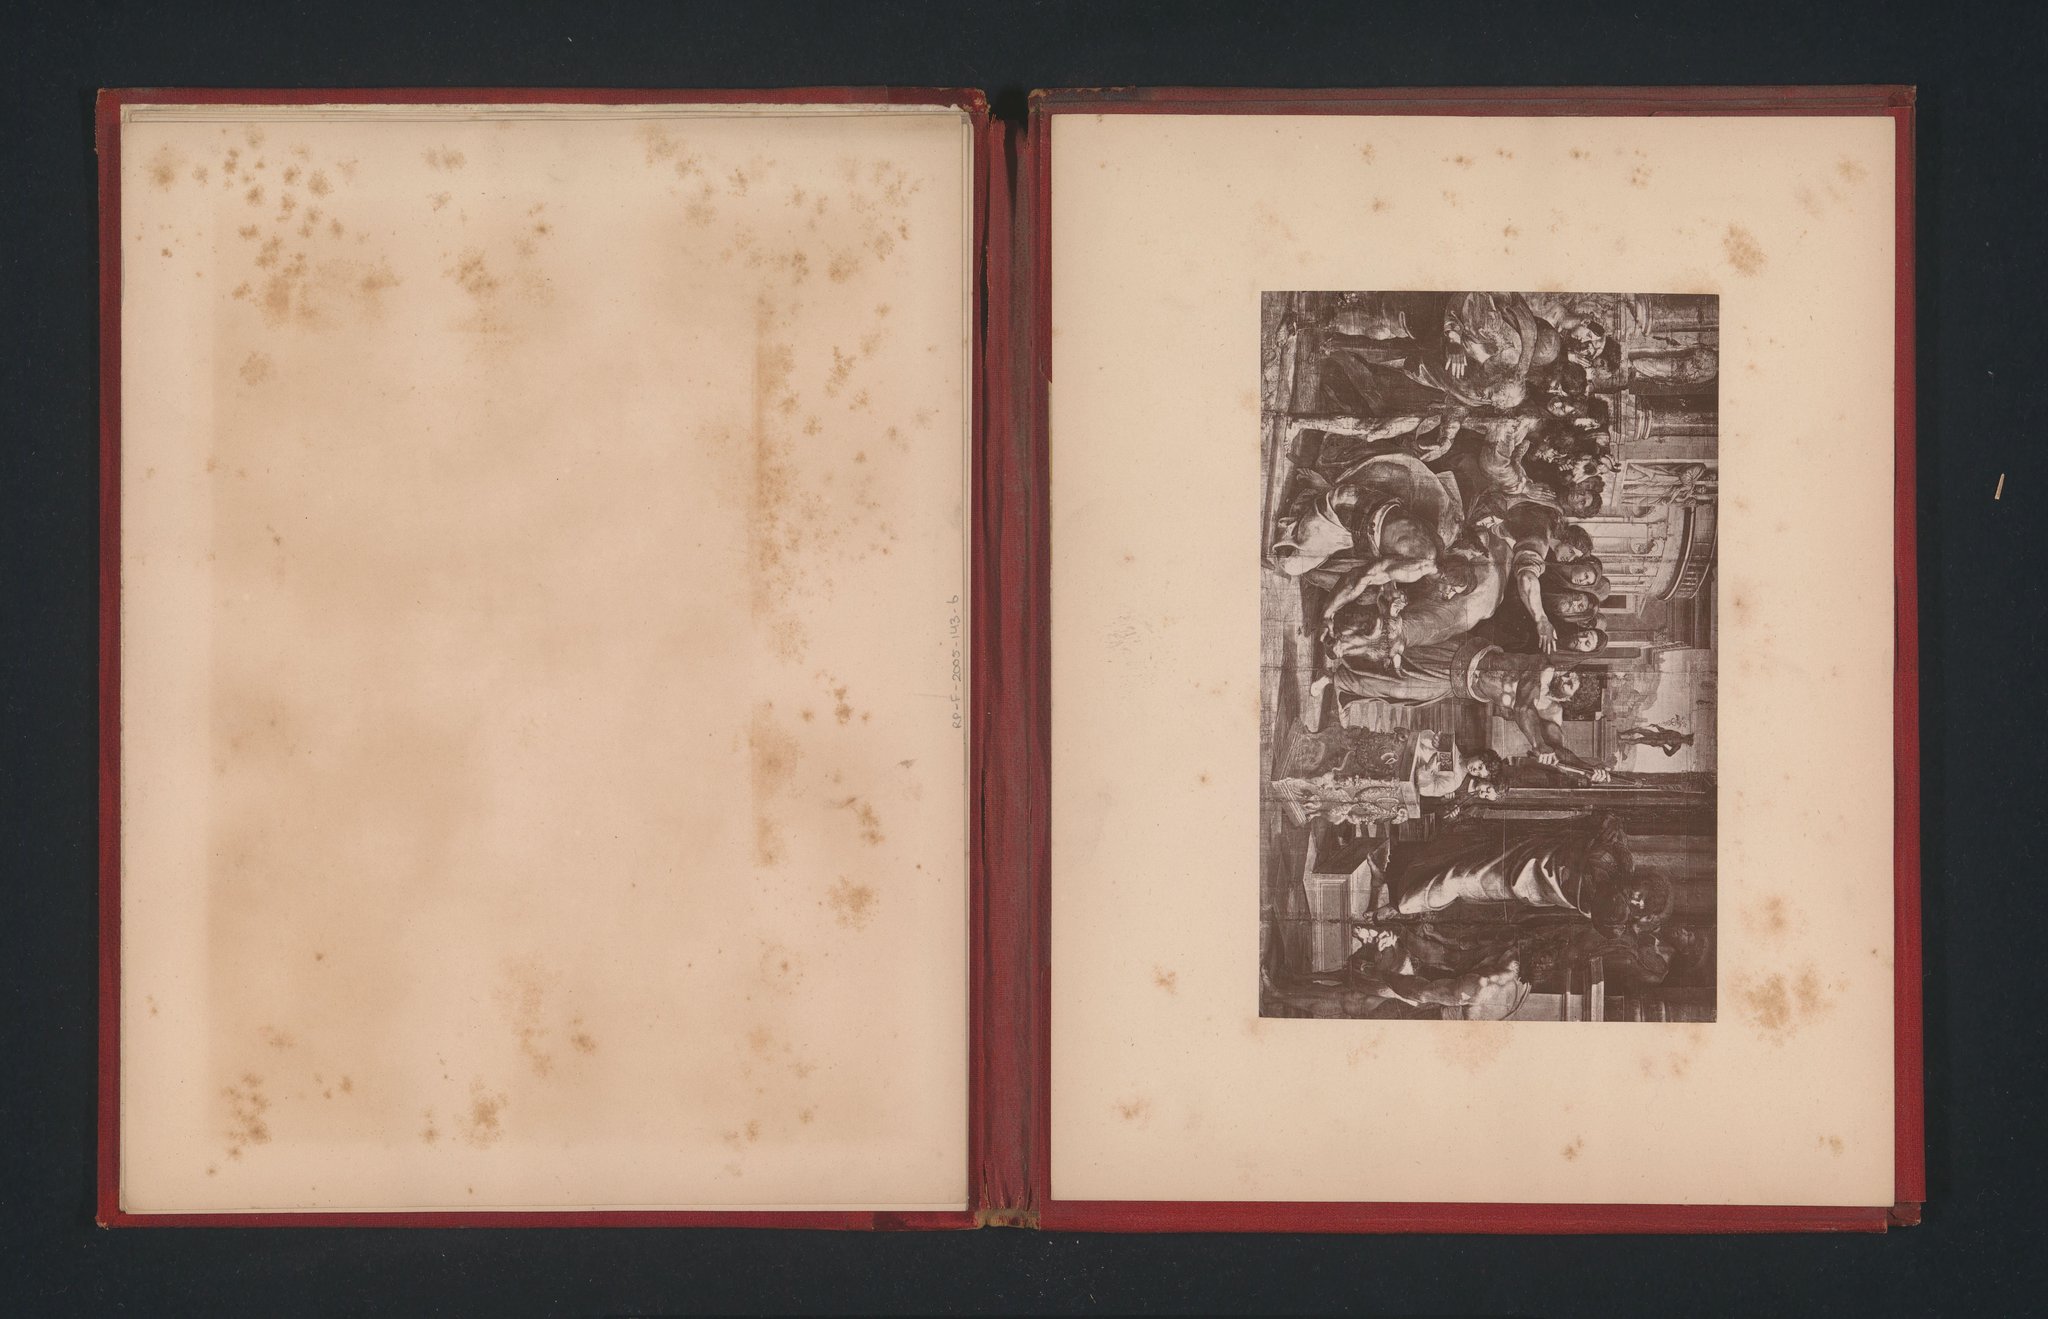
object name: photomechanical print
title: Sacrifice at Lystra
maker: charles thurston thompson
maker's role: fotograaf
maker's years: 1816-1868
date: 1880-1885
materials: paper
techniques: woodburytype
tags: paul and barnabas tear their clothes, and try to prevent the sacrifice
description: Deze prent maakt deel uit van omslag met 9 bladen.